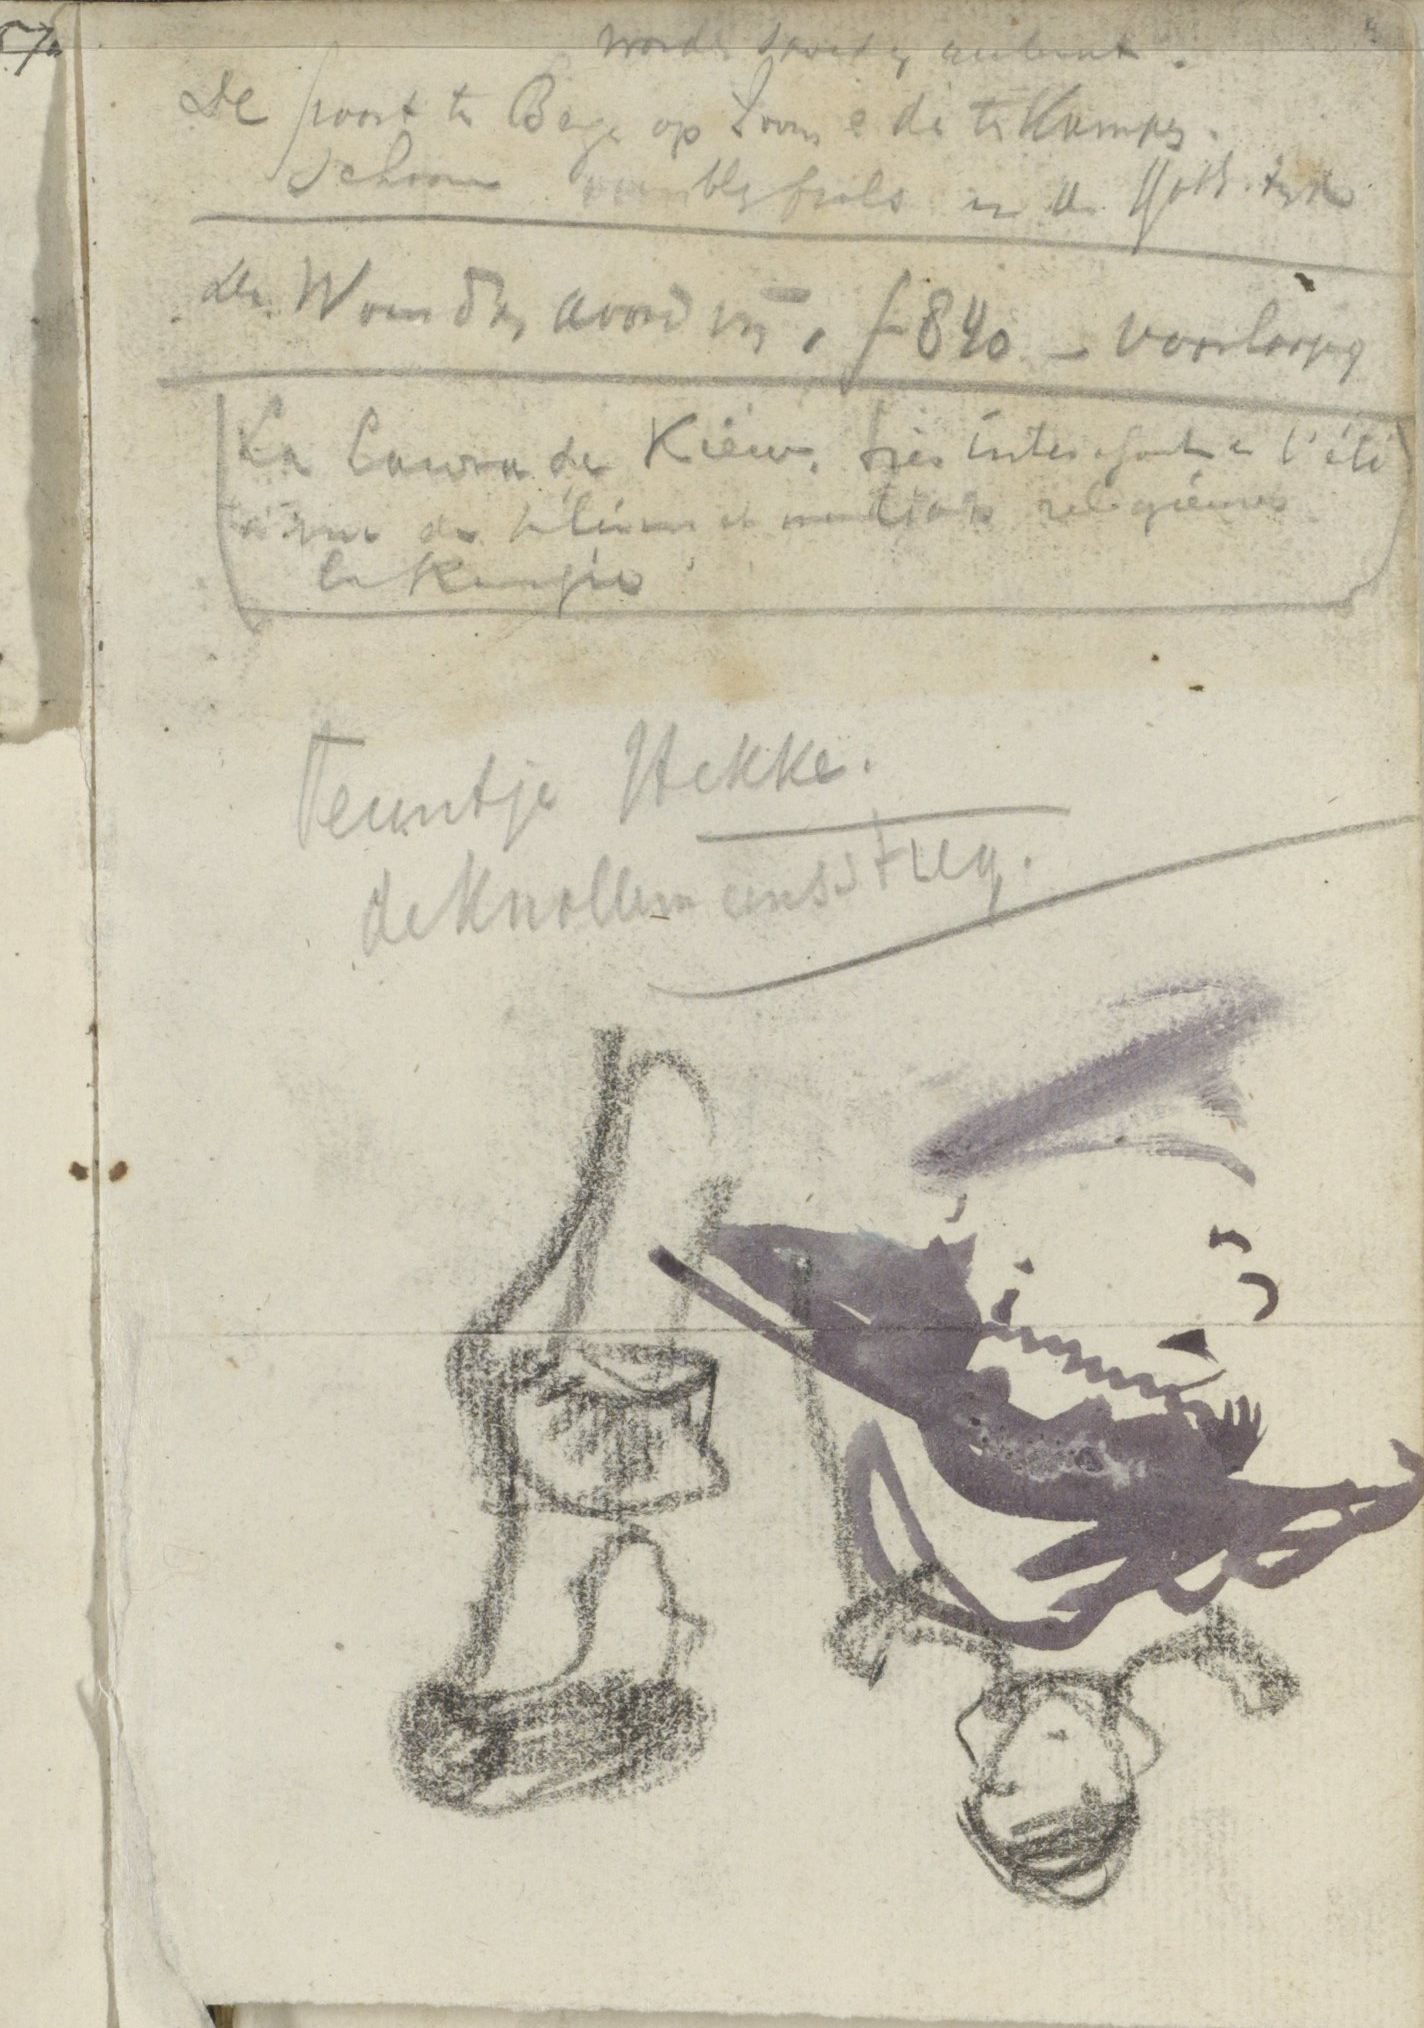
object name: sketchbook leaf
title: Studieblad met vrouwen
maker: george hendrik breitner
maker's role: draughtsman, painter, print maker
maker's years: 1857-1923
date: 1881-1883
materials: chalk, paper, watercolor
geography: rotterdam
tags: adult woman, head-gear: hat (+ women's clothes)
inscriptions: annotation: ‘[...]/ de Woensdagavond vrij, f840,- voorloopig/ La Laura de Kiew, très interessante en l'été [...]/ Teuntje Hekke/ de Knollemanssteeg’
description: Pagina 4 uit een schetsboek met 27 bladen.